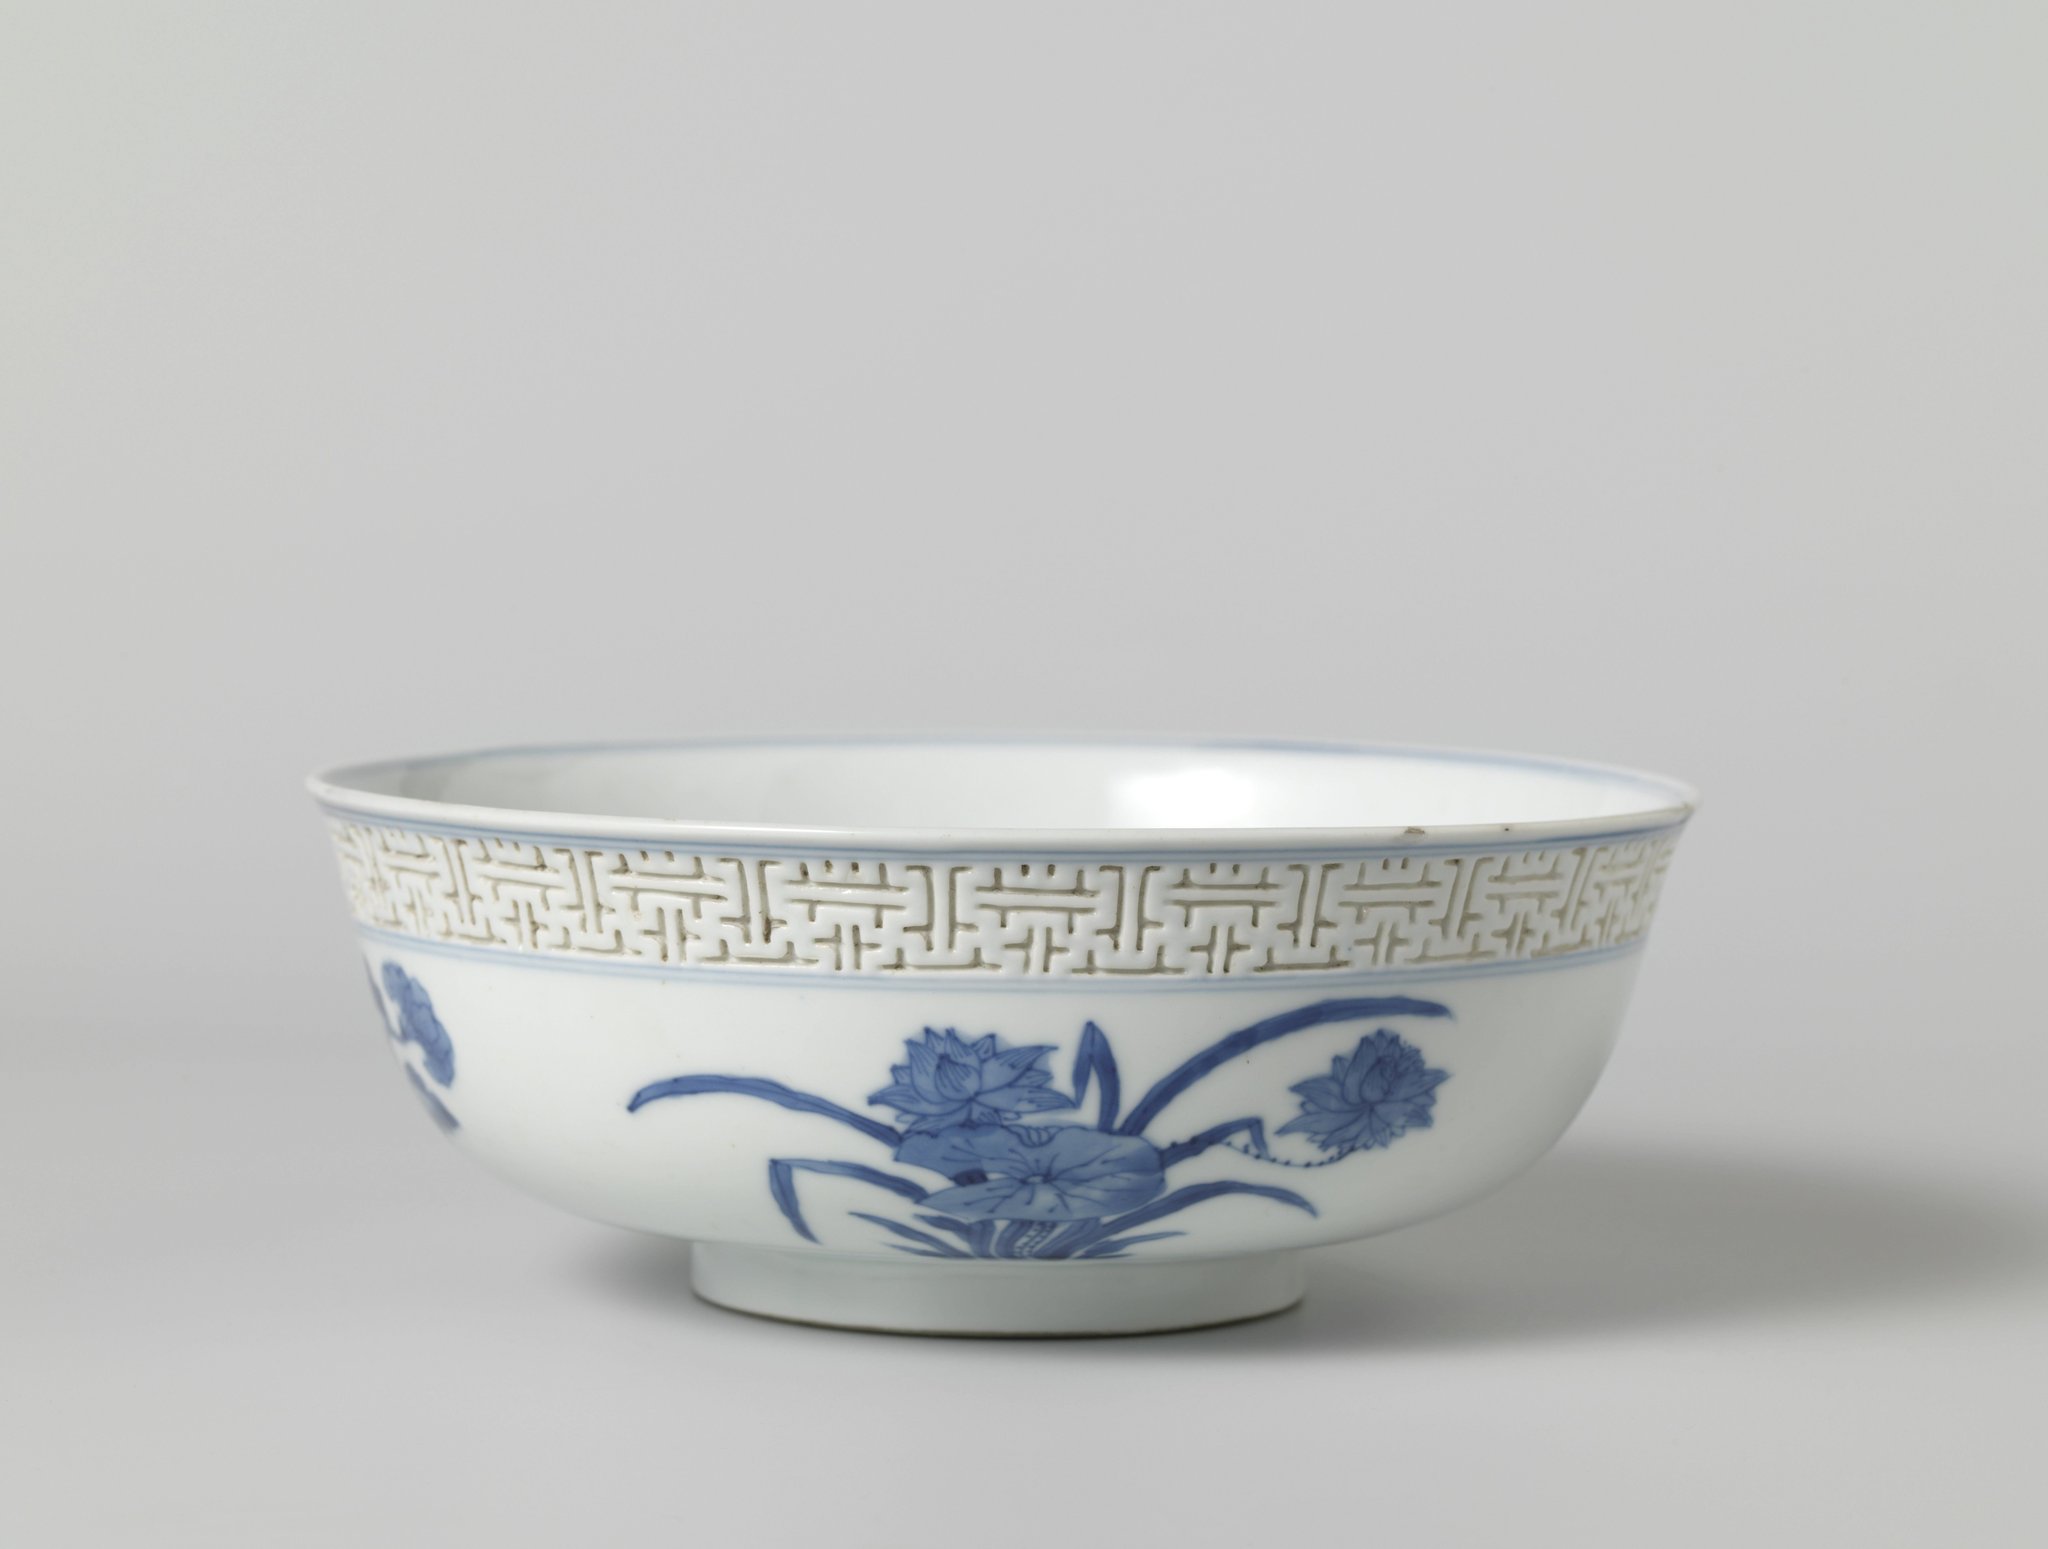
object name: bowl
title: Straight-sided bowl with figure, flower sprays and auspicious symbols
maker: Anonymous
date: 1680-1720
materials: cobalt, glaze, paint, porcelain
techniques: engraving, firing, forming, turning, vitrification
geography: china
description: Wijde kom met een vrijwel rechte wand, op een standring en met een geprononceerde bolling in het plat. Aan de buitenzijde beschilderd met vier verschillende bloeiende planten, aan de binnenzijde met vier maal de taoistische onsterfelijke Lan Tsai Ho en rond de bolling acht geluksymbolen.